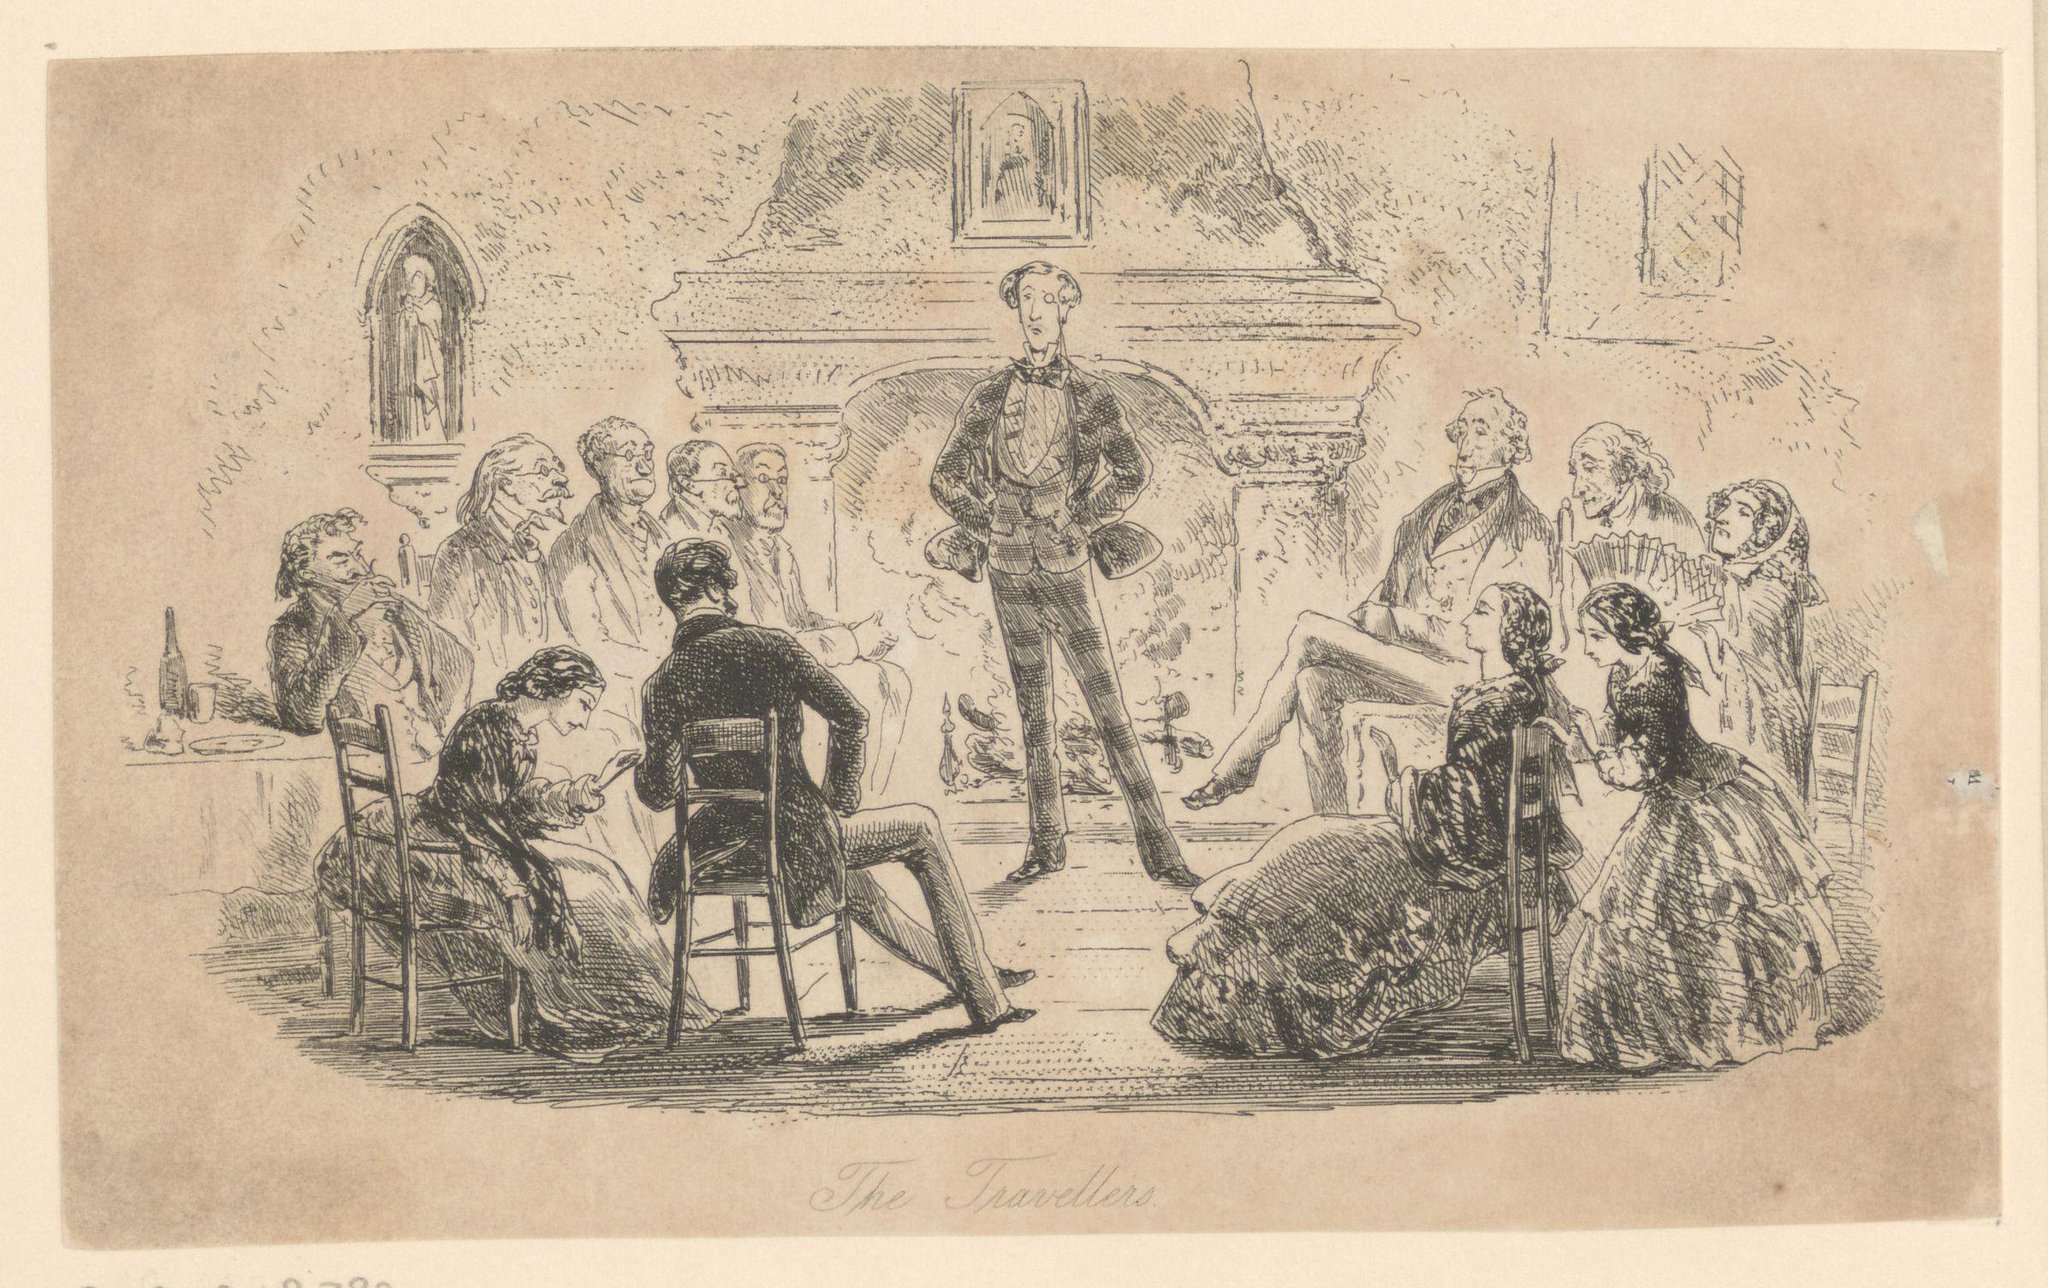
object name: print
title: Groep reizigers waaronder de familie Dorrit zit in een kamer met haard in de Alpen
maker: hablot knight browne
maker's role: print maker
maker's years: 1815-1882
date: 1857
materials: paper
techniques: etching, roulette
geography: london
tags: open hearth, fire-place, living-room, parlour, sitting-room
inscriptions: collector's mark: Lugt 2228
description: Prent uit: Dickens, Charles. Little Dorrit. Londen: Bradbury & Evans, 1857.